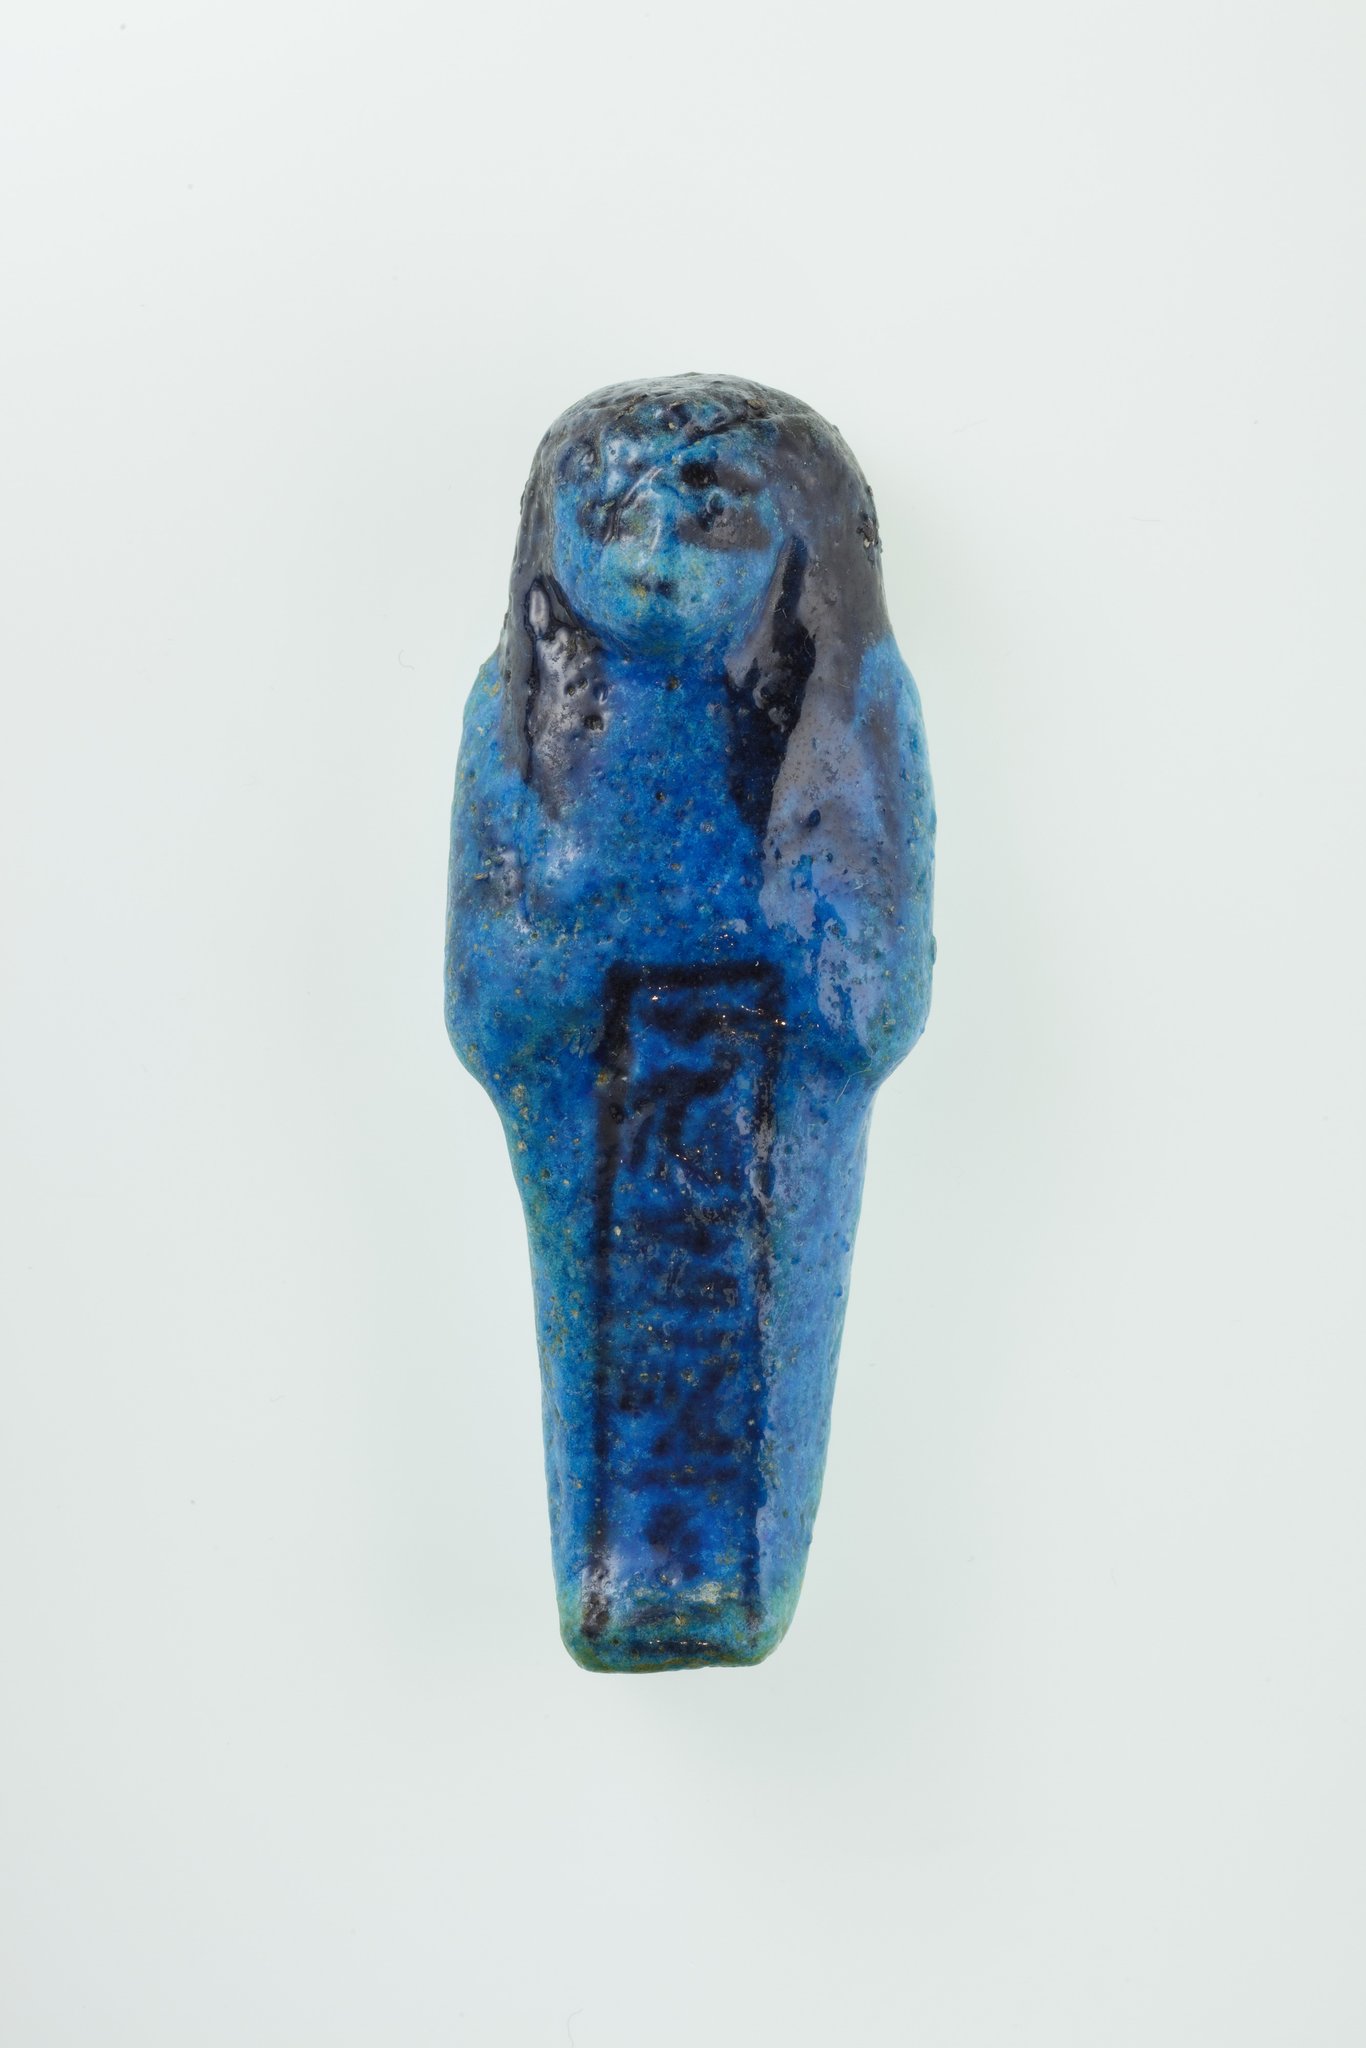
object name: shabti, worker, nauny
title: Worker Shabti of Nauny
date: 1050 BCE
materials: faience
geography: egypt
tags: hieroglyphs